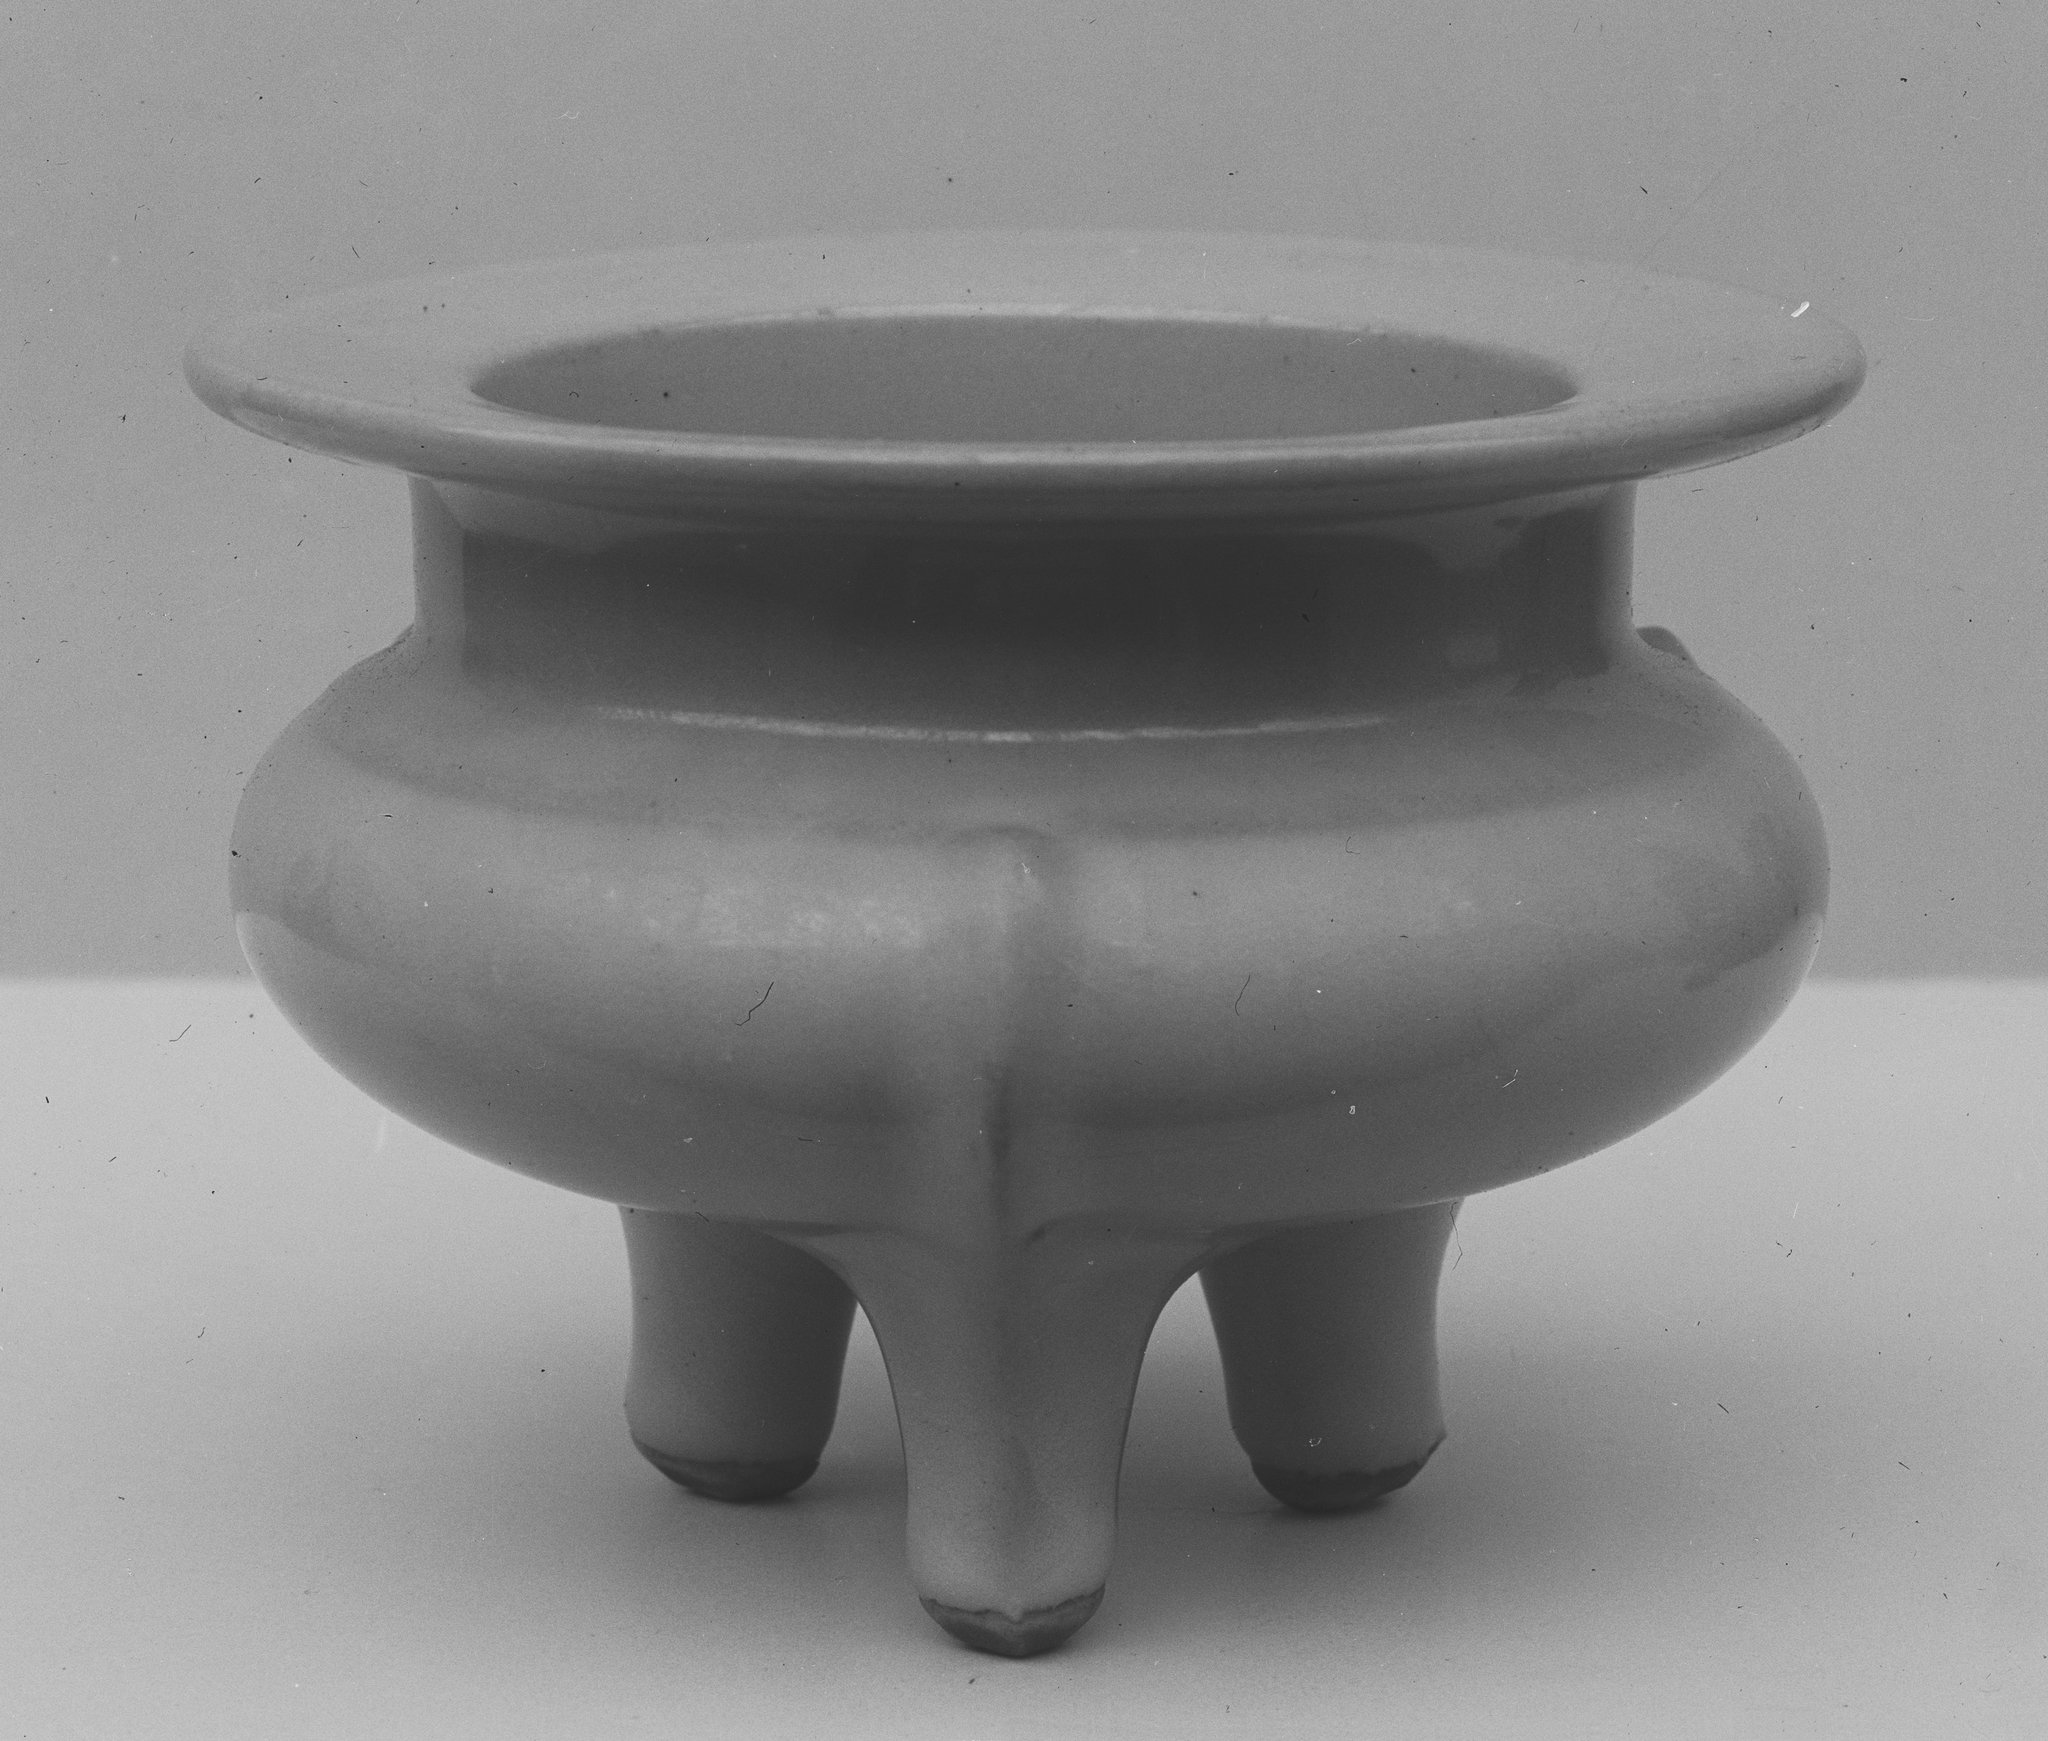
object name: incense burner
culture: chinese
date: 1899-1922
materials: porcelain